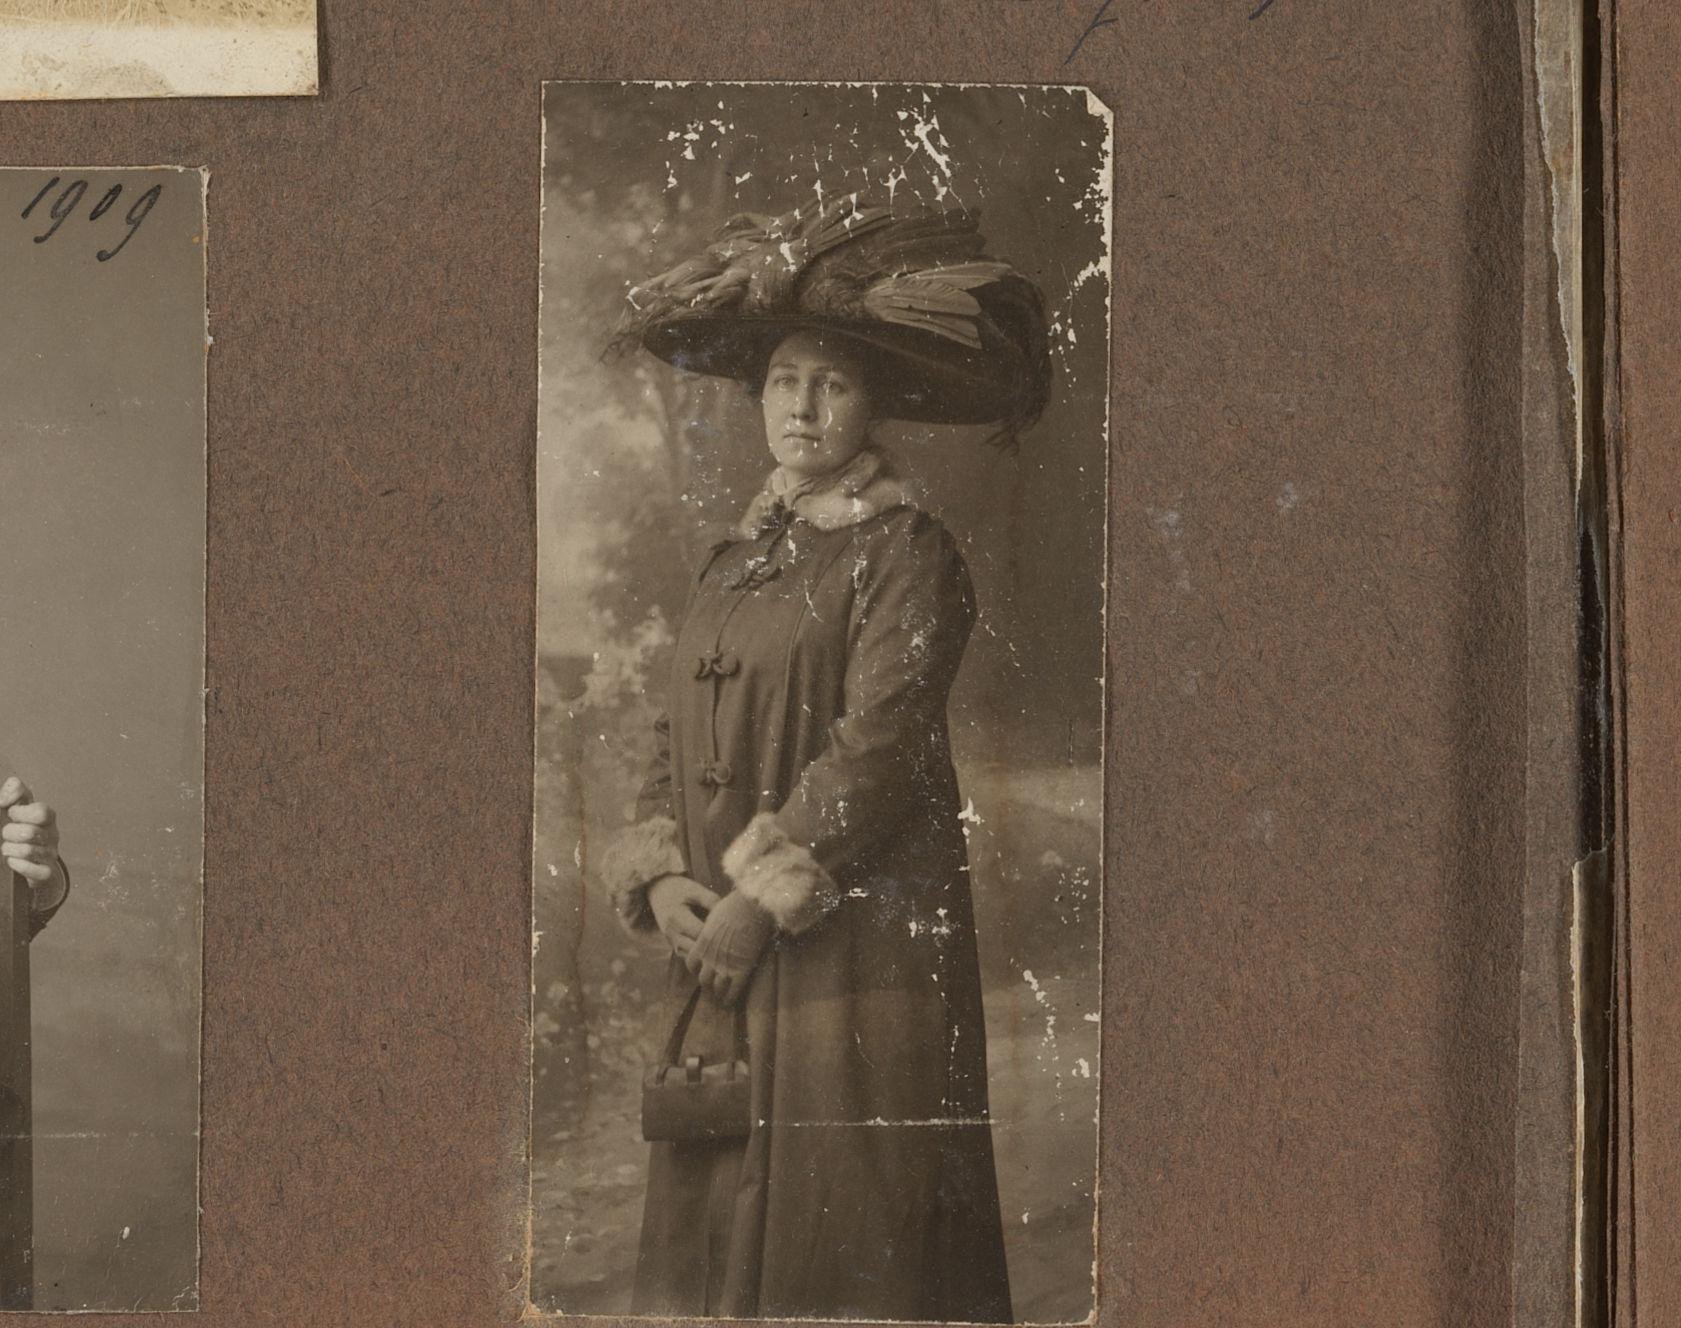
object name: photograph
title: Moeder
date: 1909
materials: photographic support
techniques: photography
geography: netherlands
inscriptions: date: ‘1909.’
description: Foto op bruin albumblad 24 van familiealbum van Alphons Diepenbrock.